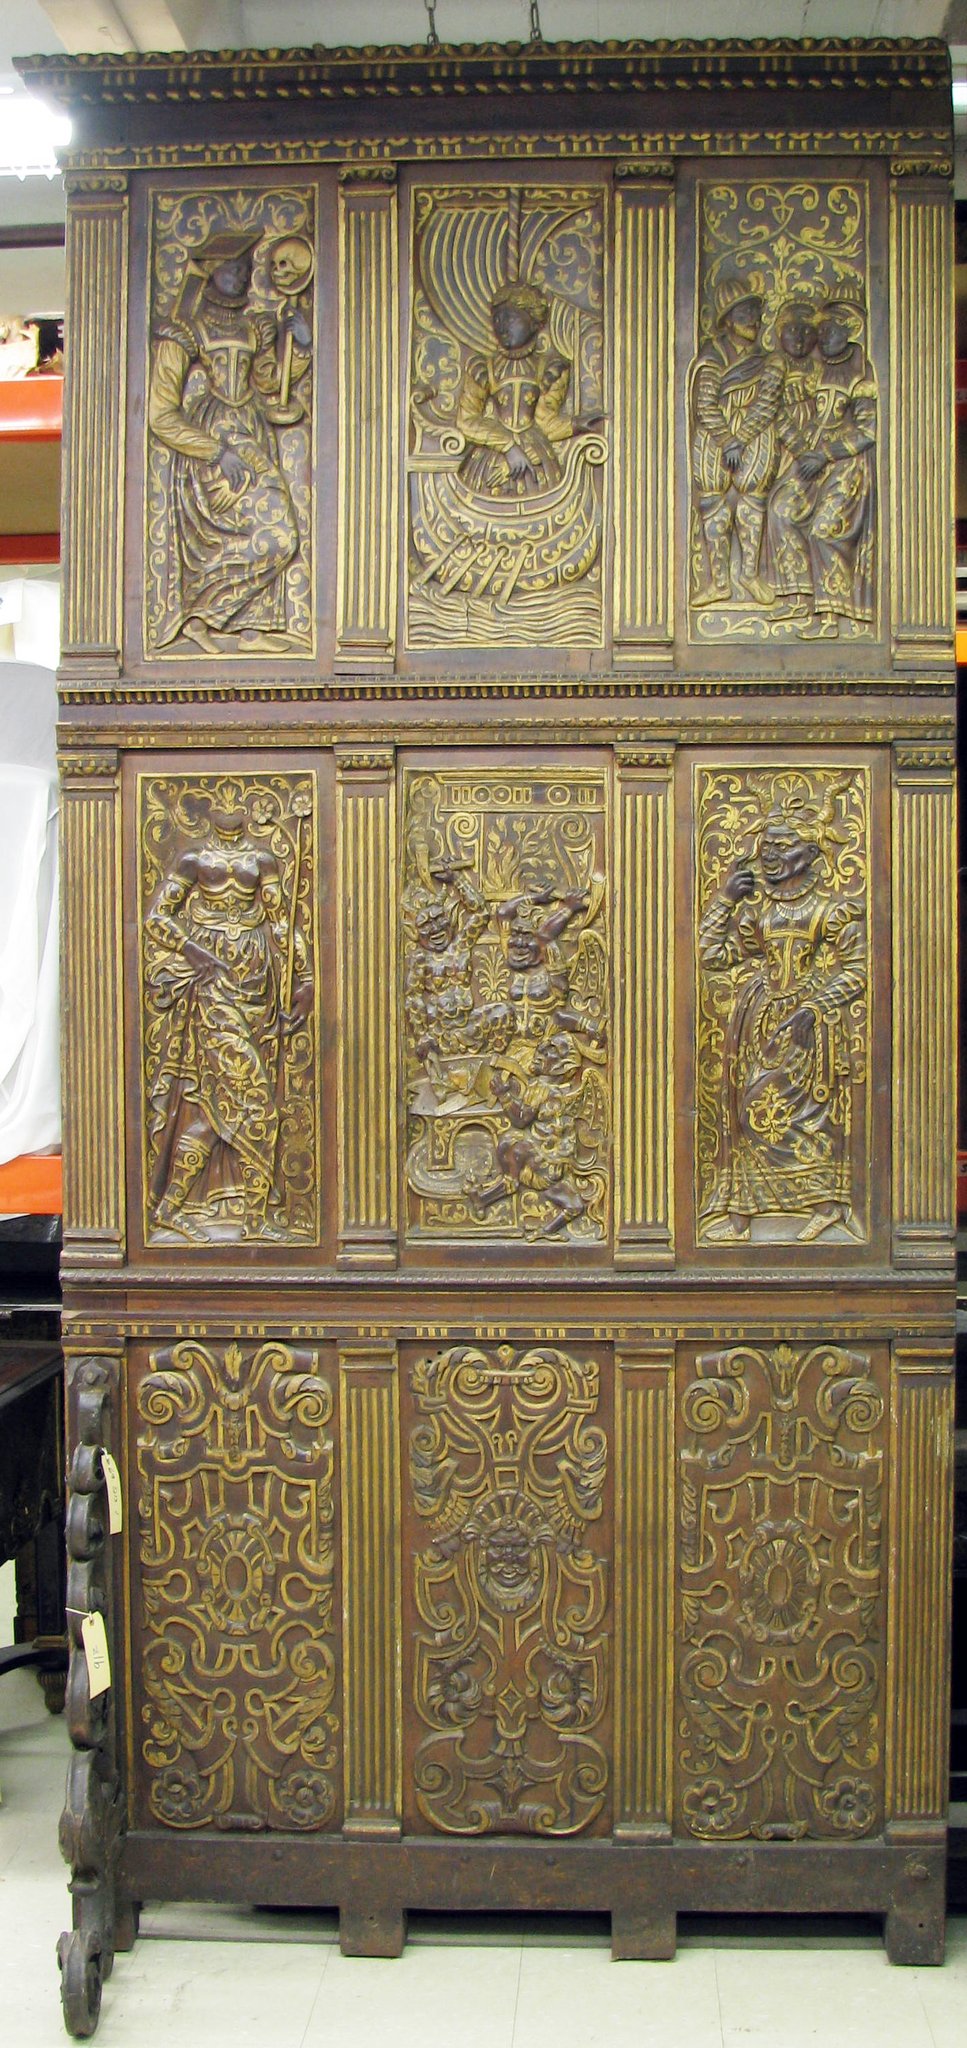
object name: paneling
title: Pair of paneling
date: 1576-1600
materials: iron, velvet, wood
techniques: carving, gilding, painting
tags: skulls,men,women,demons,ships